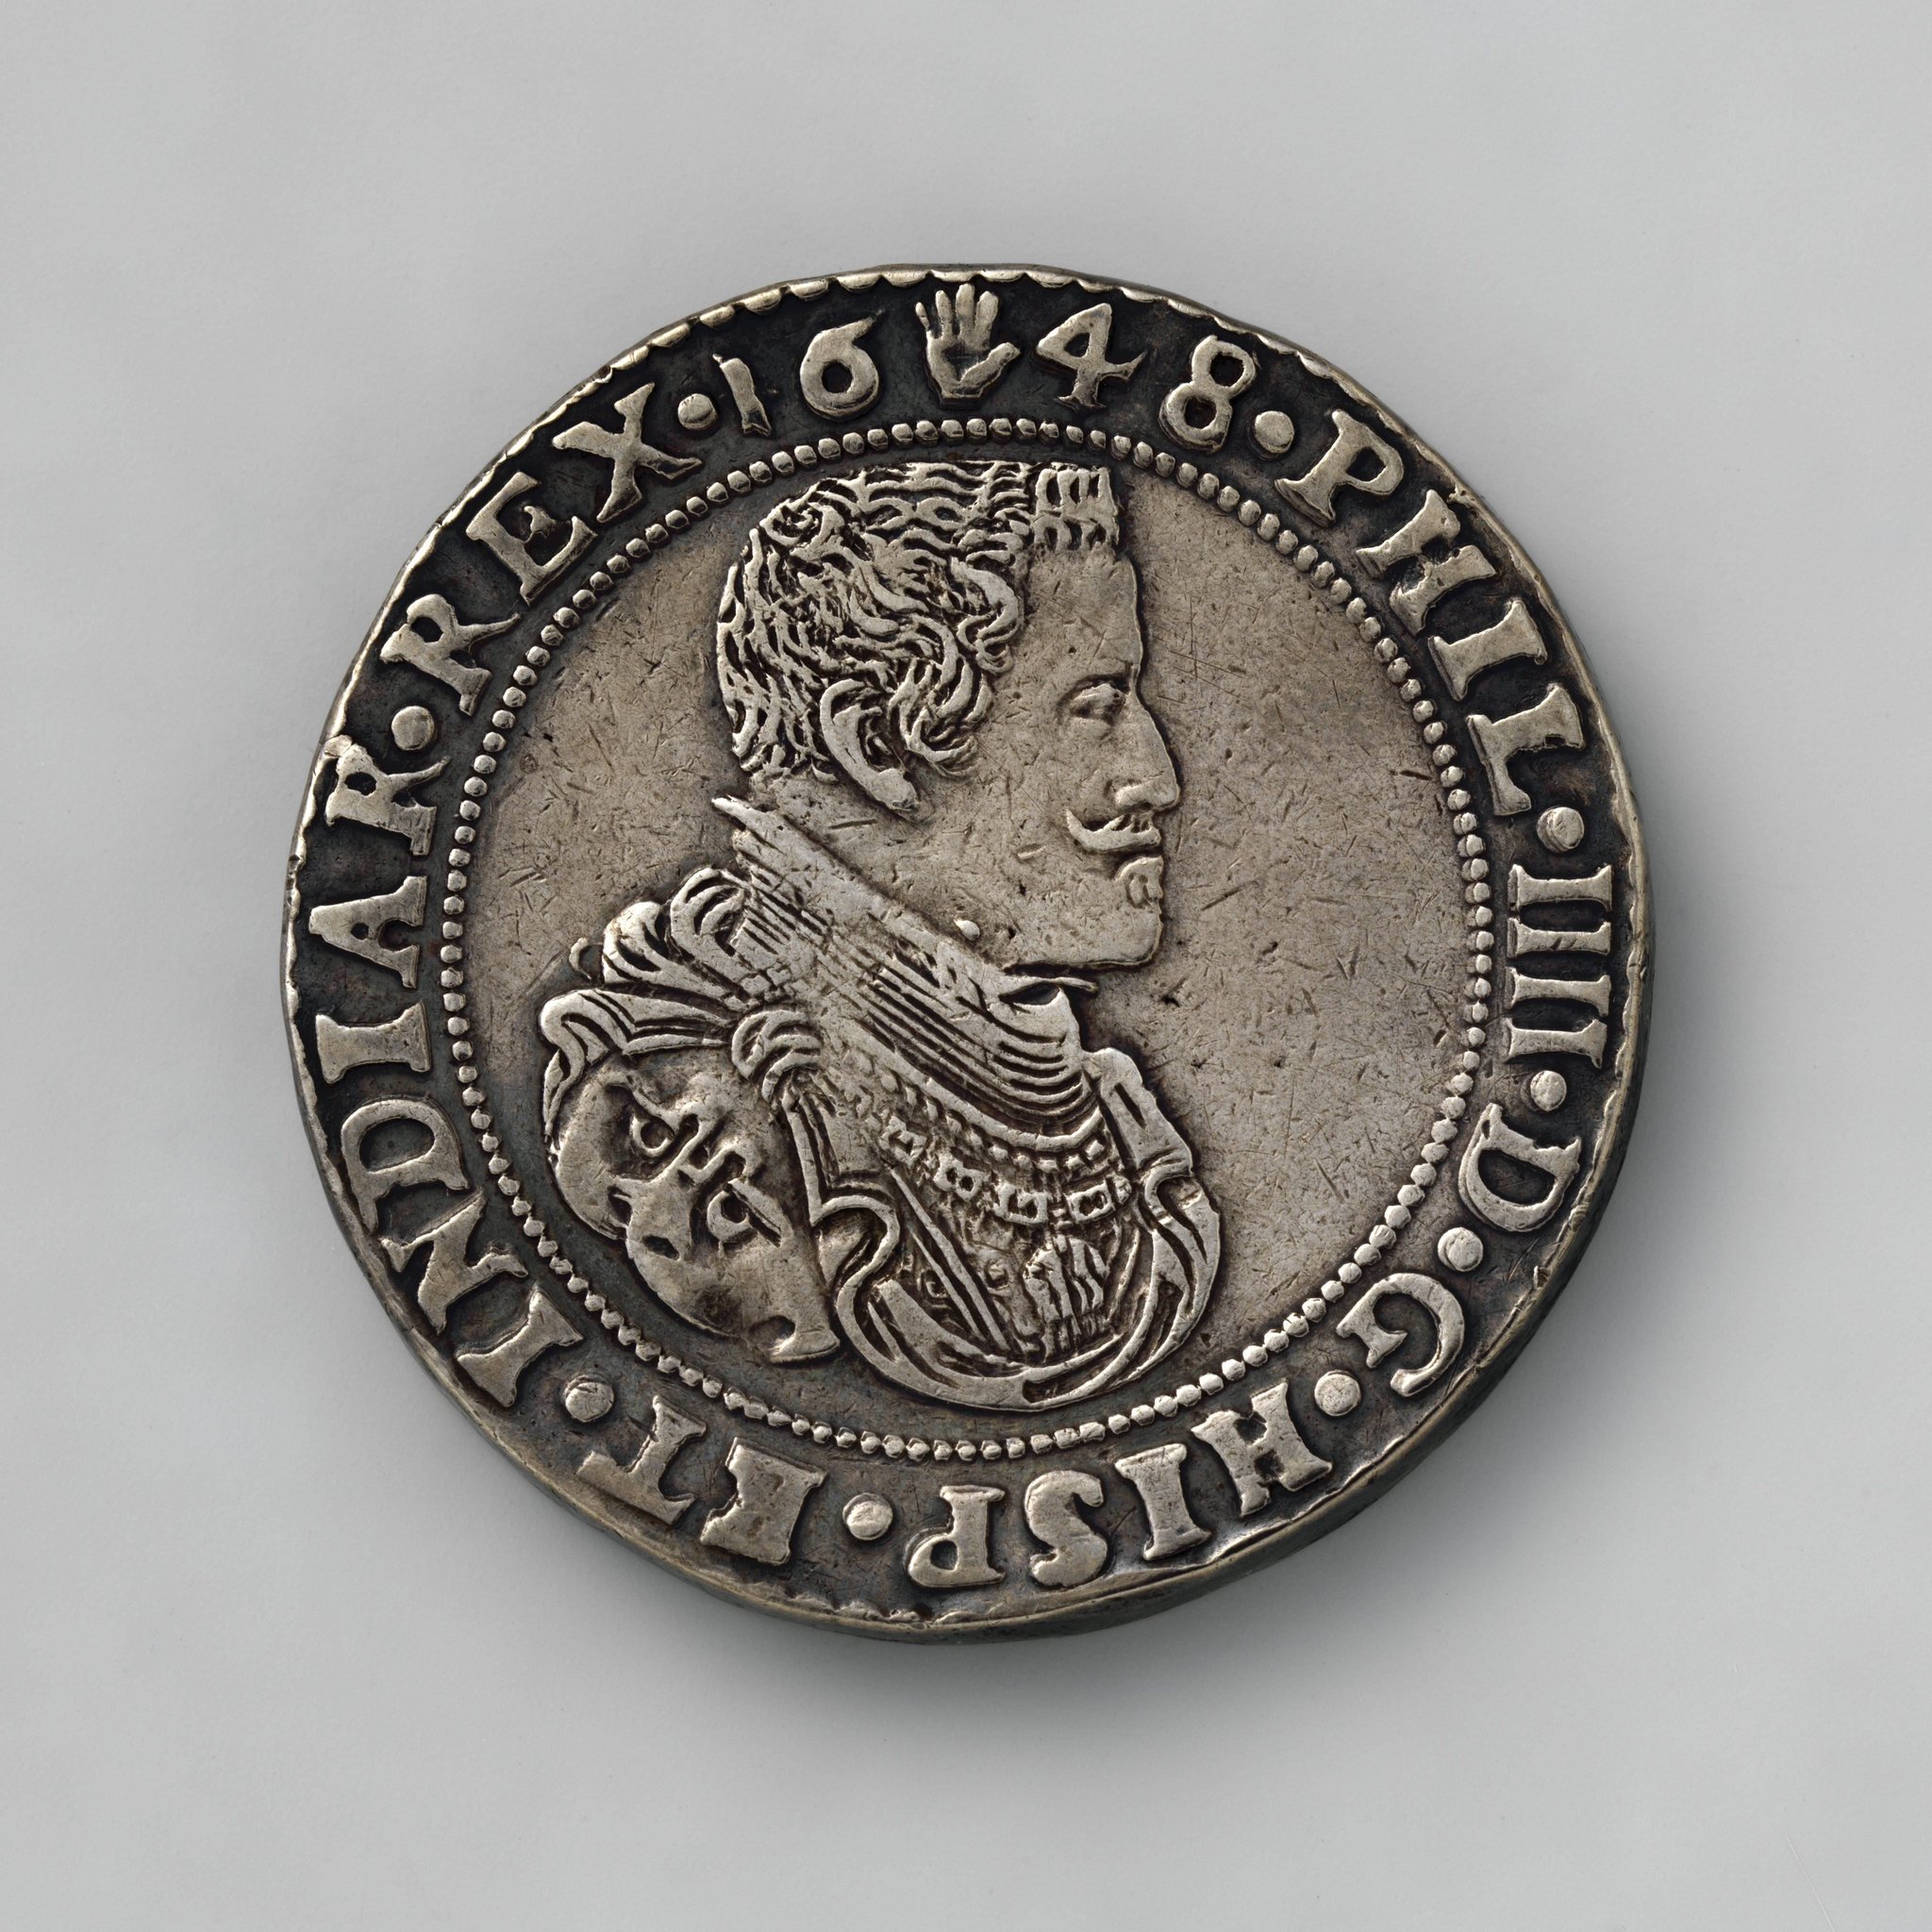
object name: ducatoon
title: Piedfort van een dukaton uit Brabant van Philips IV, 1648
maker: Anonymous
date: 1648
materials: silver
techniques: striking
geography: antwerp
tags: filips iv (koning van spanje), spain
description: Zilveren munt. Voorzijde: portret van Philips IV naar rechts. Jaartal, waartussen hand, in omschrift. Keerzijde: door twee leeuwen gehouden gekroond samengesteld wapenschild. Onder wapenschild twee naar elkaar gekeerde vuurijzers met vonken, waaronder gulden vlies. Piedfort.